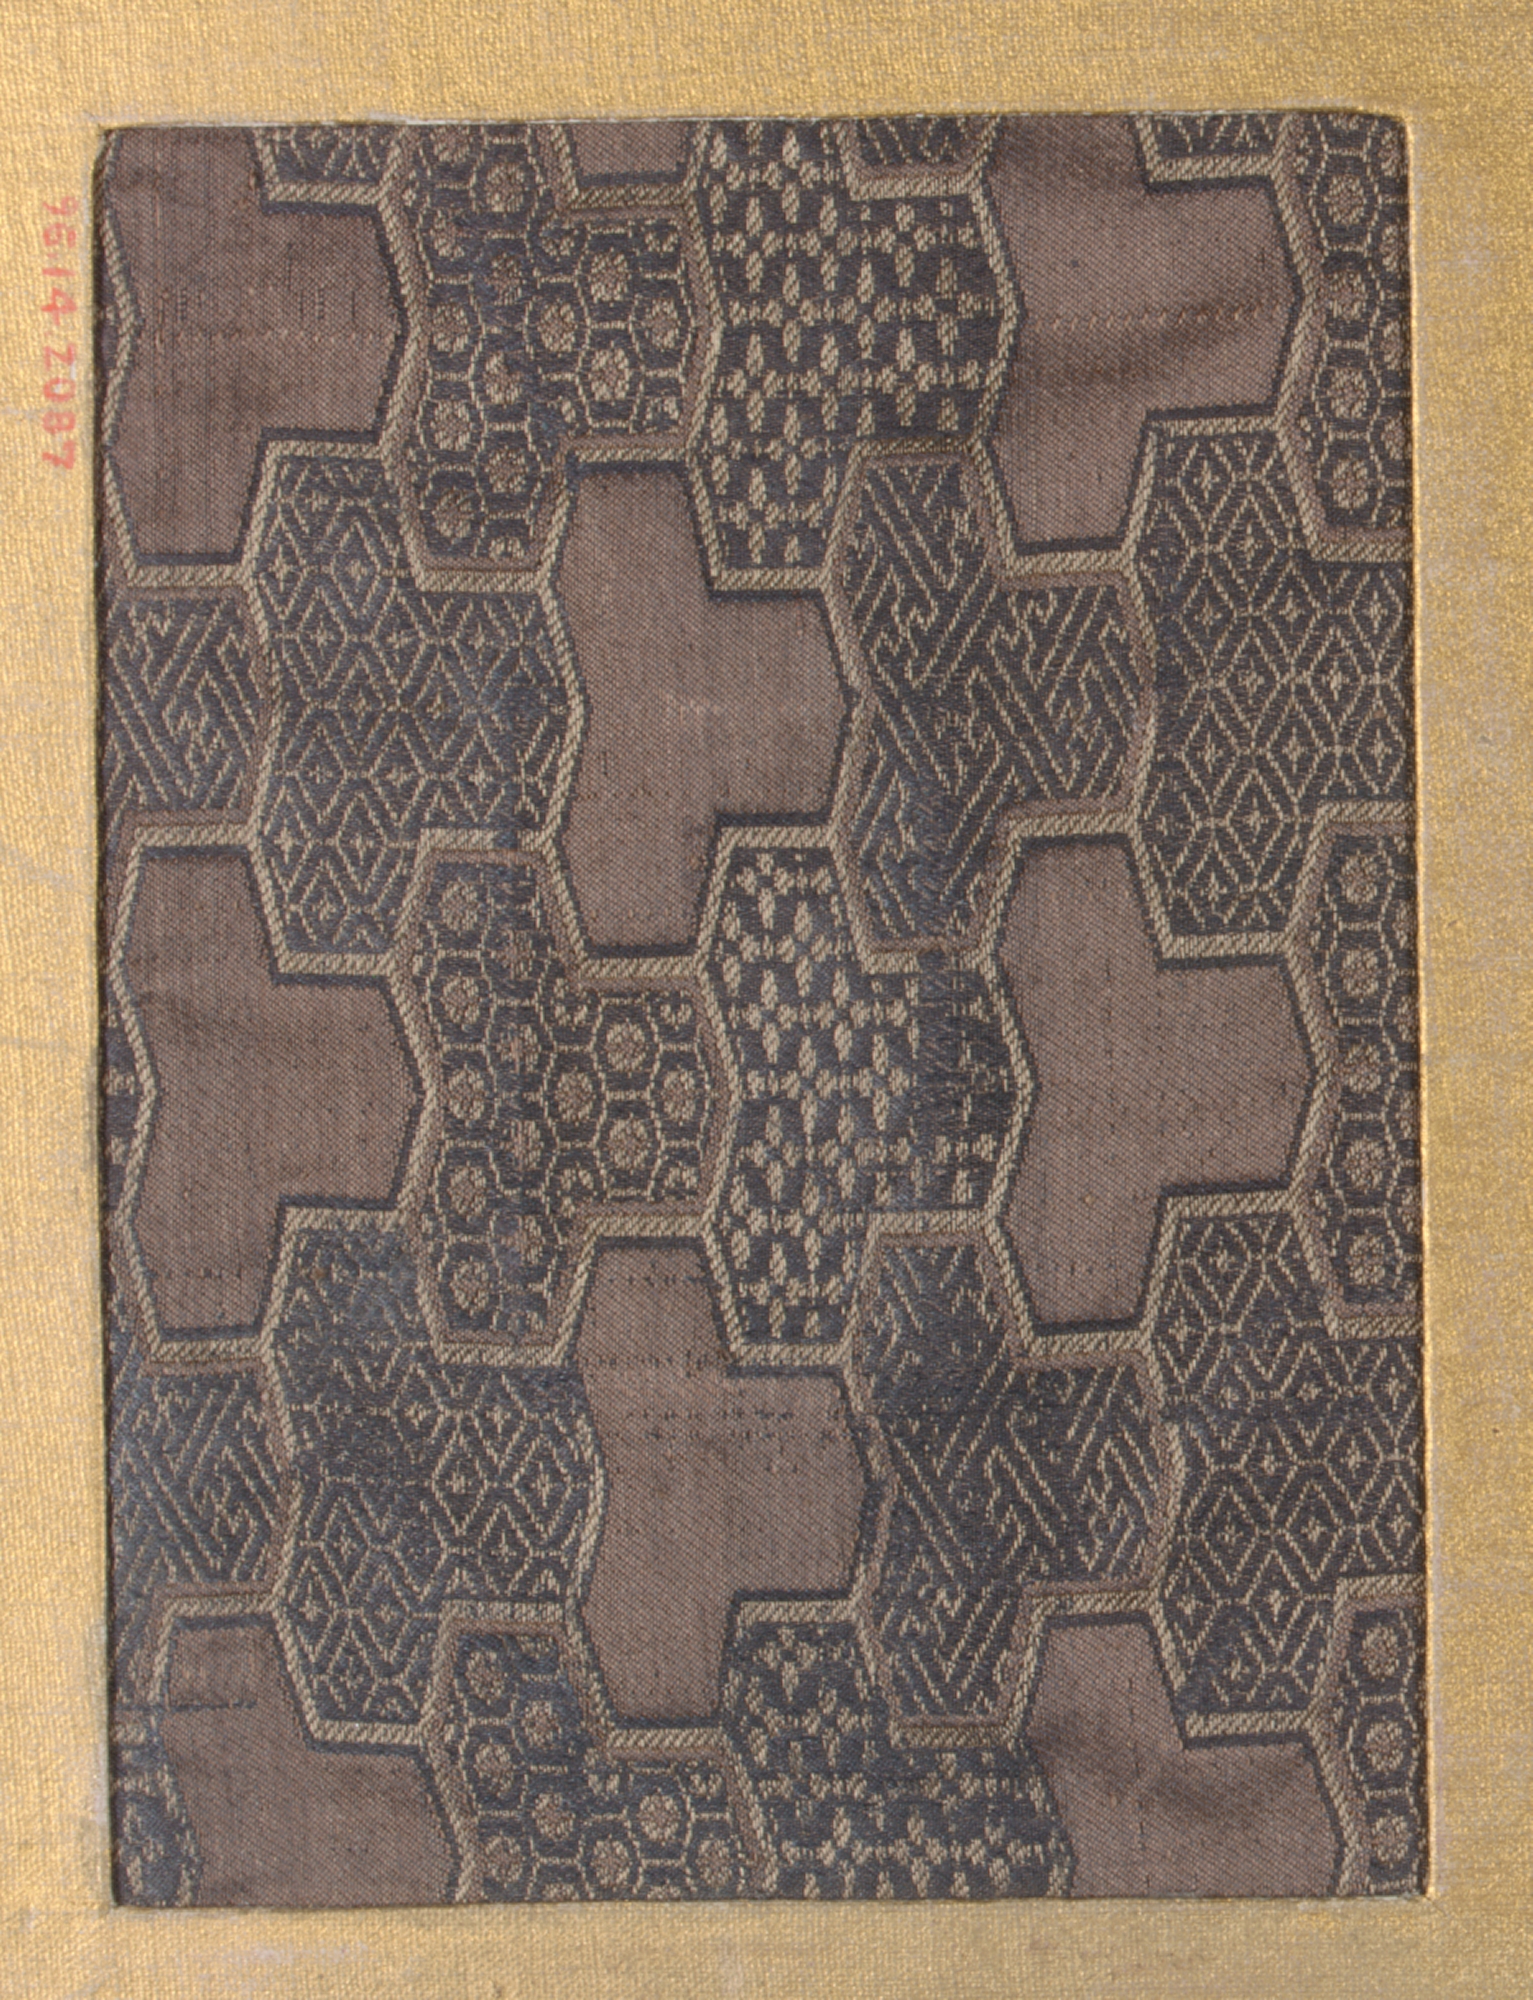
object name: piece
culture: japanese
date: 1701-1900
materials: silk